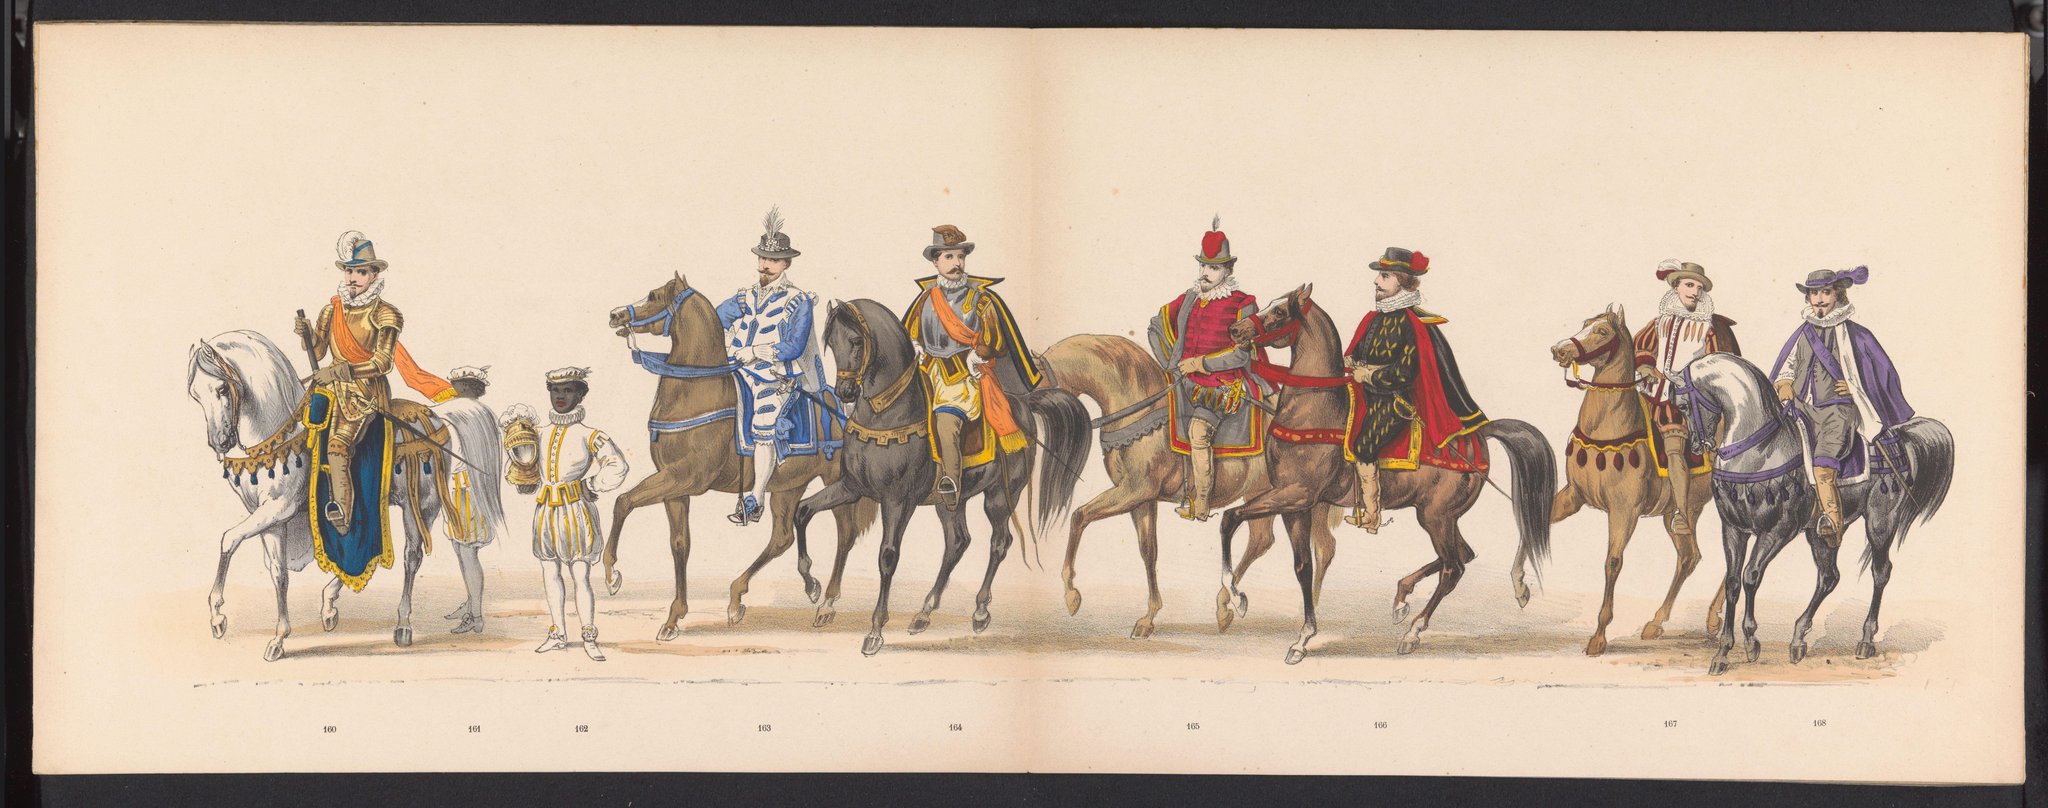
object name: print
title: Maskerade van de Leidse studenten, 1875 (plaat 10)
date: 1875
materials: paper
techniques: hand coloring, lithograph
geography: netherlands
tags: students' pageant, costumes used in pageants, leiden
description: Historische gekostumeerde optocht van de studenten van de Leidse Hogeschool gehouden op 15 juni 1875 ter gelegenheid van het 300-jarig bestaan van de Hogeschool. De optocht verbeeldt de beroemdste mannen verbonden aan de Hogeschool. Tiende plaat met de groepen genummerd 160-168. Onderdeel van de serie van 21 aaneen geplakte bladen.